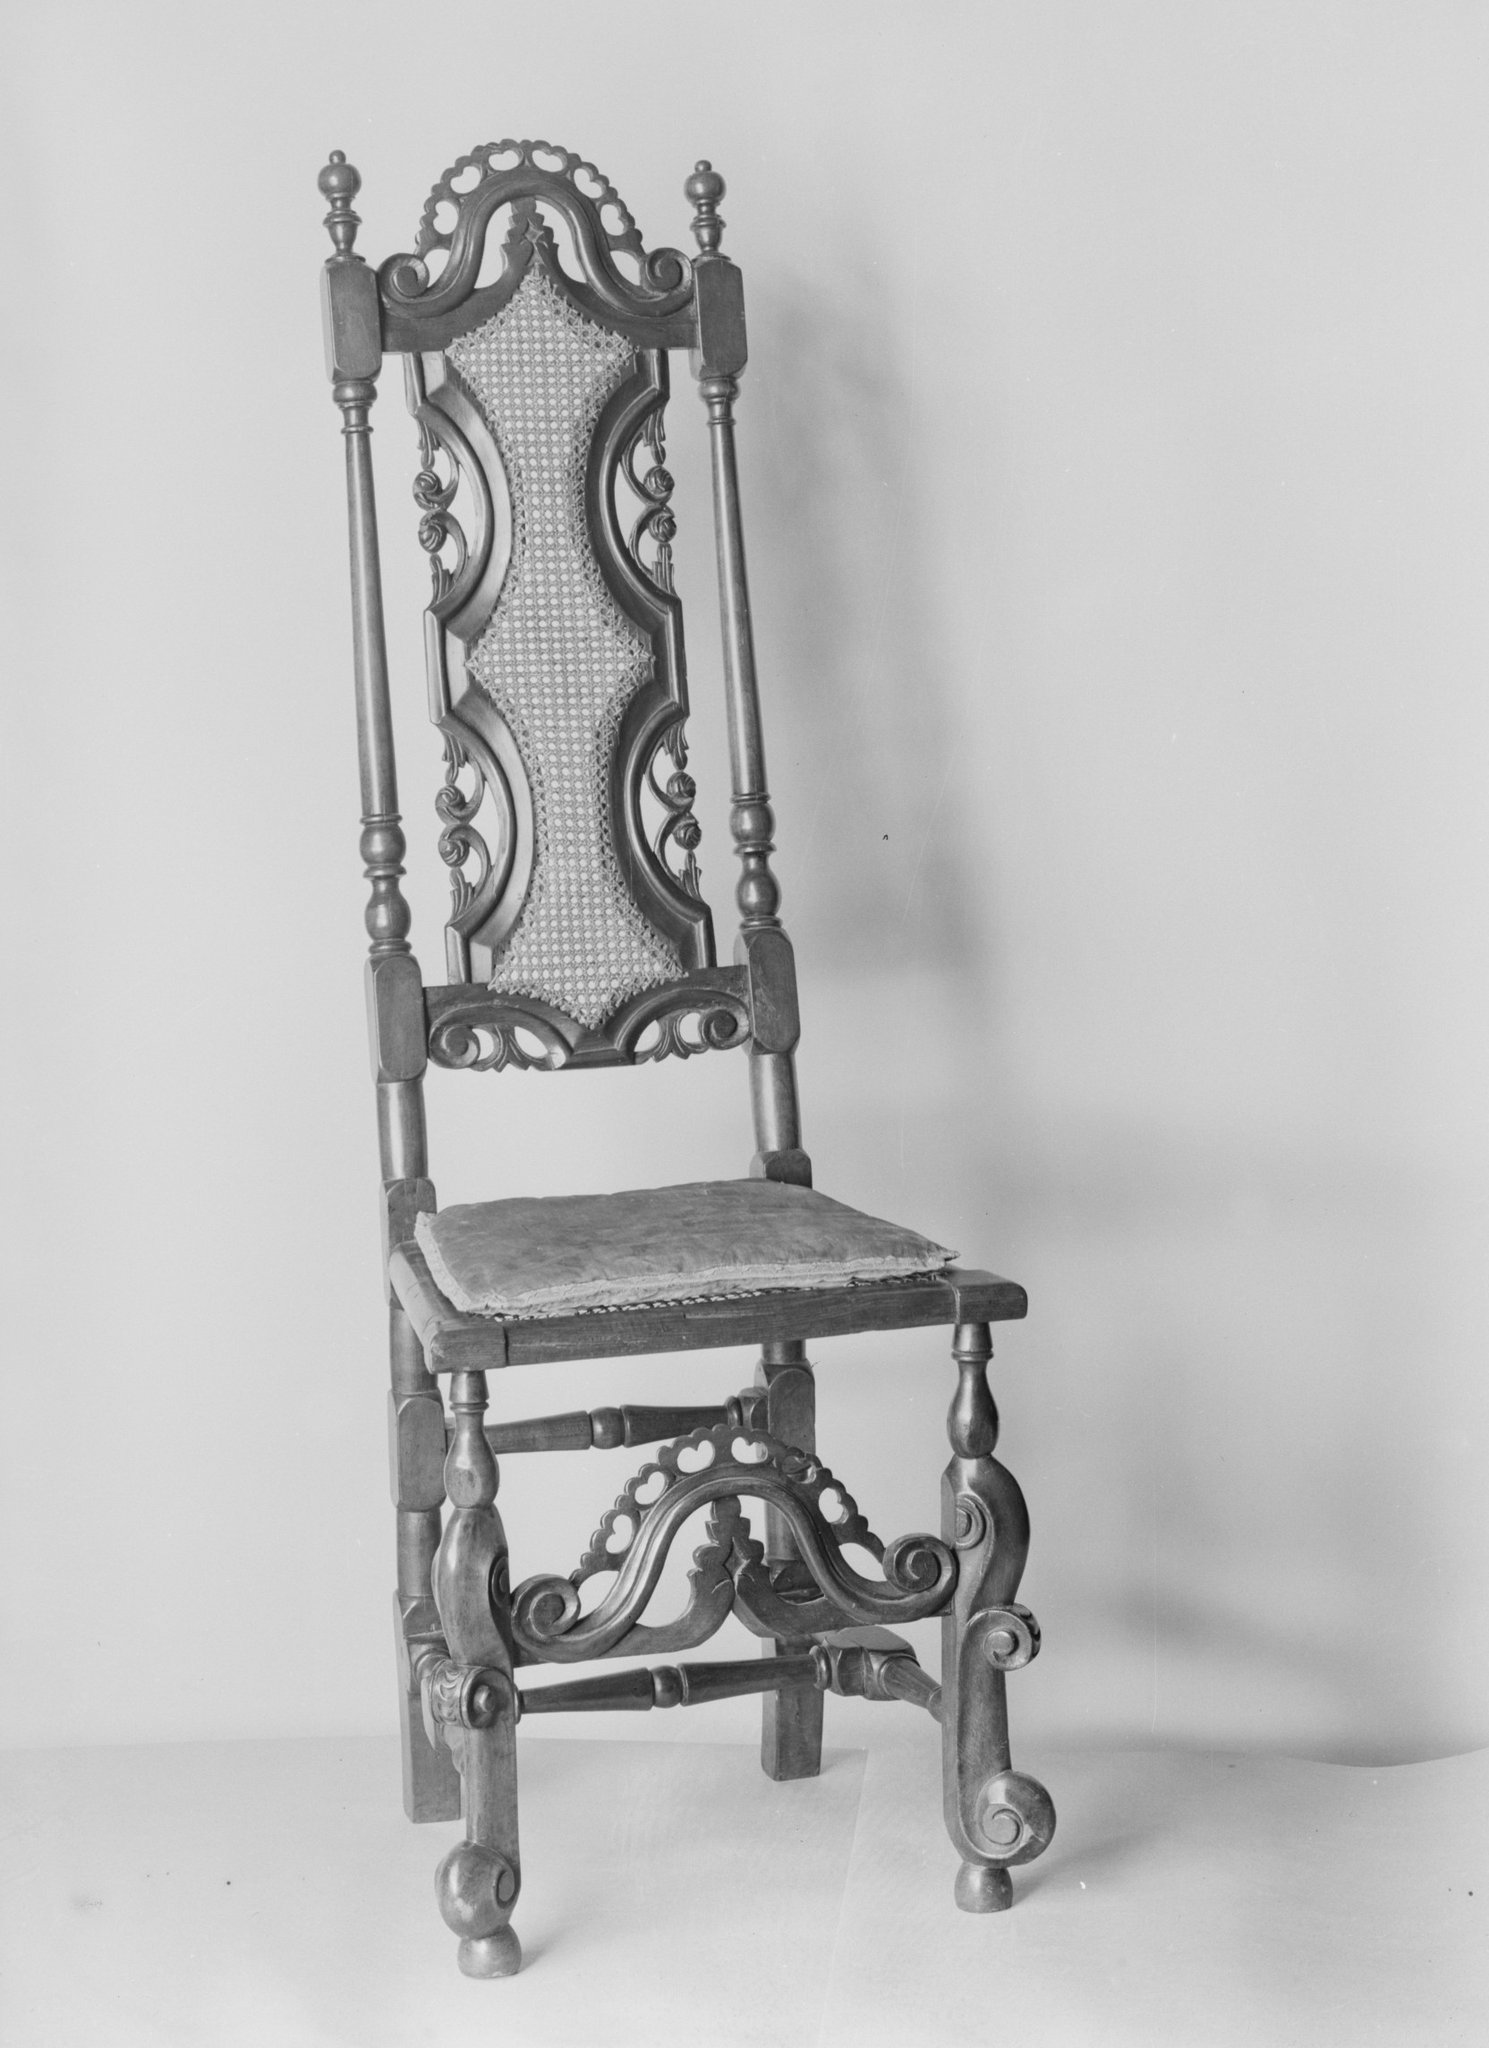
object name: side chair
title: Cane side chair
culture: british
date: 1690-1710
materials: wood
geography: england